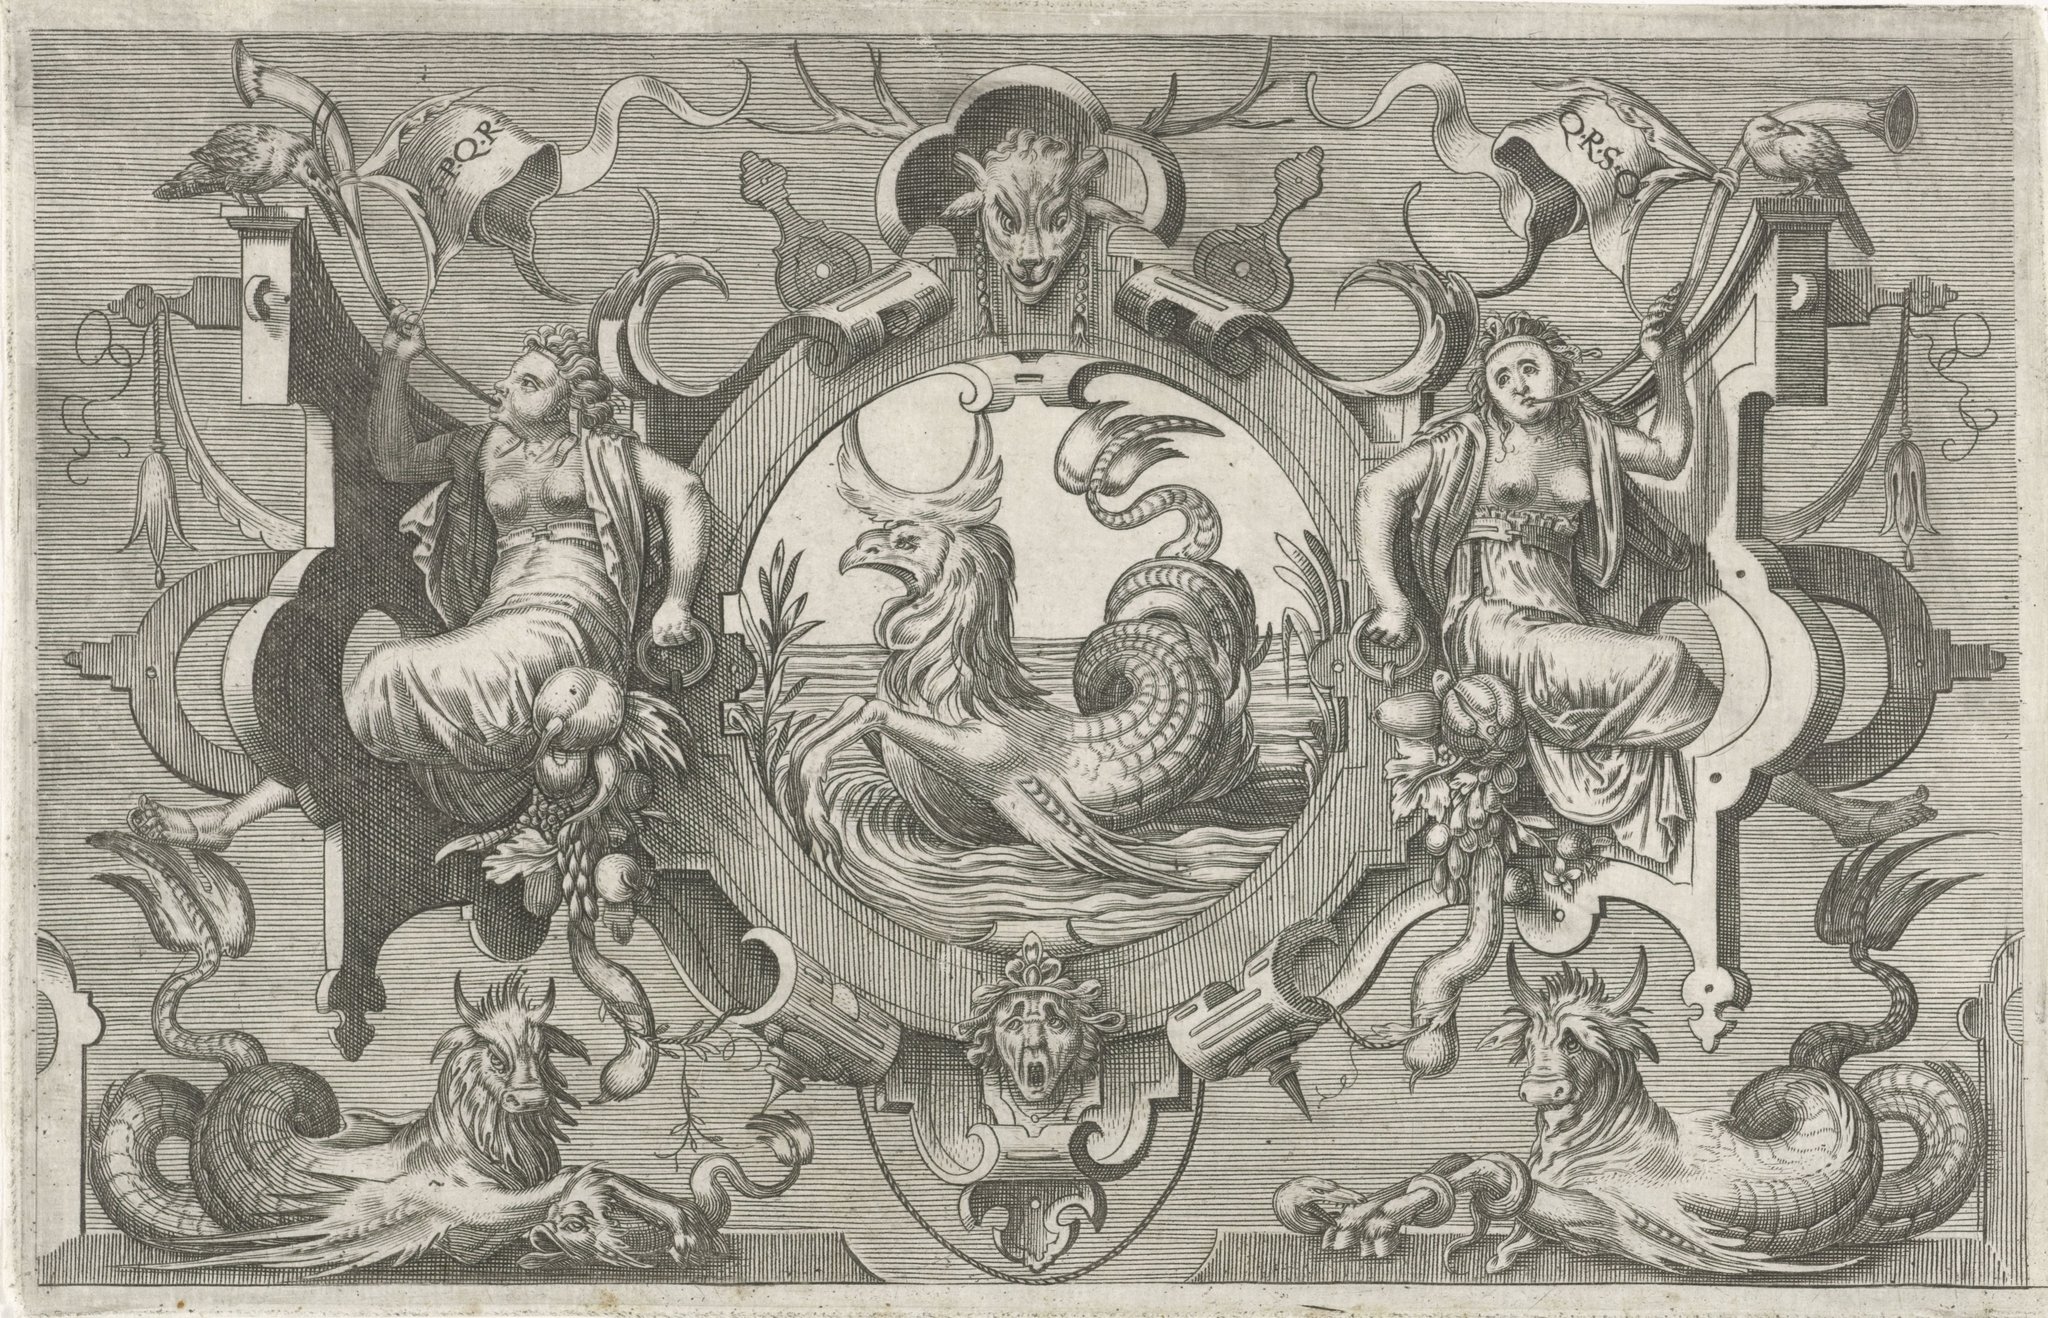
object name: ornament print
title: Veelderhande cierlijcke compertementen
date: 1564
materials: paper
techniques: engraving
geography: antwerp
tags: fabulous animals (sometimes wrongly called 'grotesques'); 'mostri' (ripa), ornament ~ cartouche, mask, mascaron ~ ornament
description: Cartouche met een zeewezen, voorzien van een hanenkop, een lange gekrulde vissenstaart en voorpoten. De cartouche heeft een omlijsting van krulwerk. Links en rechts een vrouw die op een horen blaast. Aan de horen hangt een vlag. Onder de cartouche twee fantasiewezens. Dit wezen heeft het hoofd en de poten van een rund en de staart van een vis. Onder de voorpoten klemmen zij een vis en een slang. Gearceerde achtergrond. Onderdeel van serie met titelblad en 12 bladen.